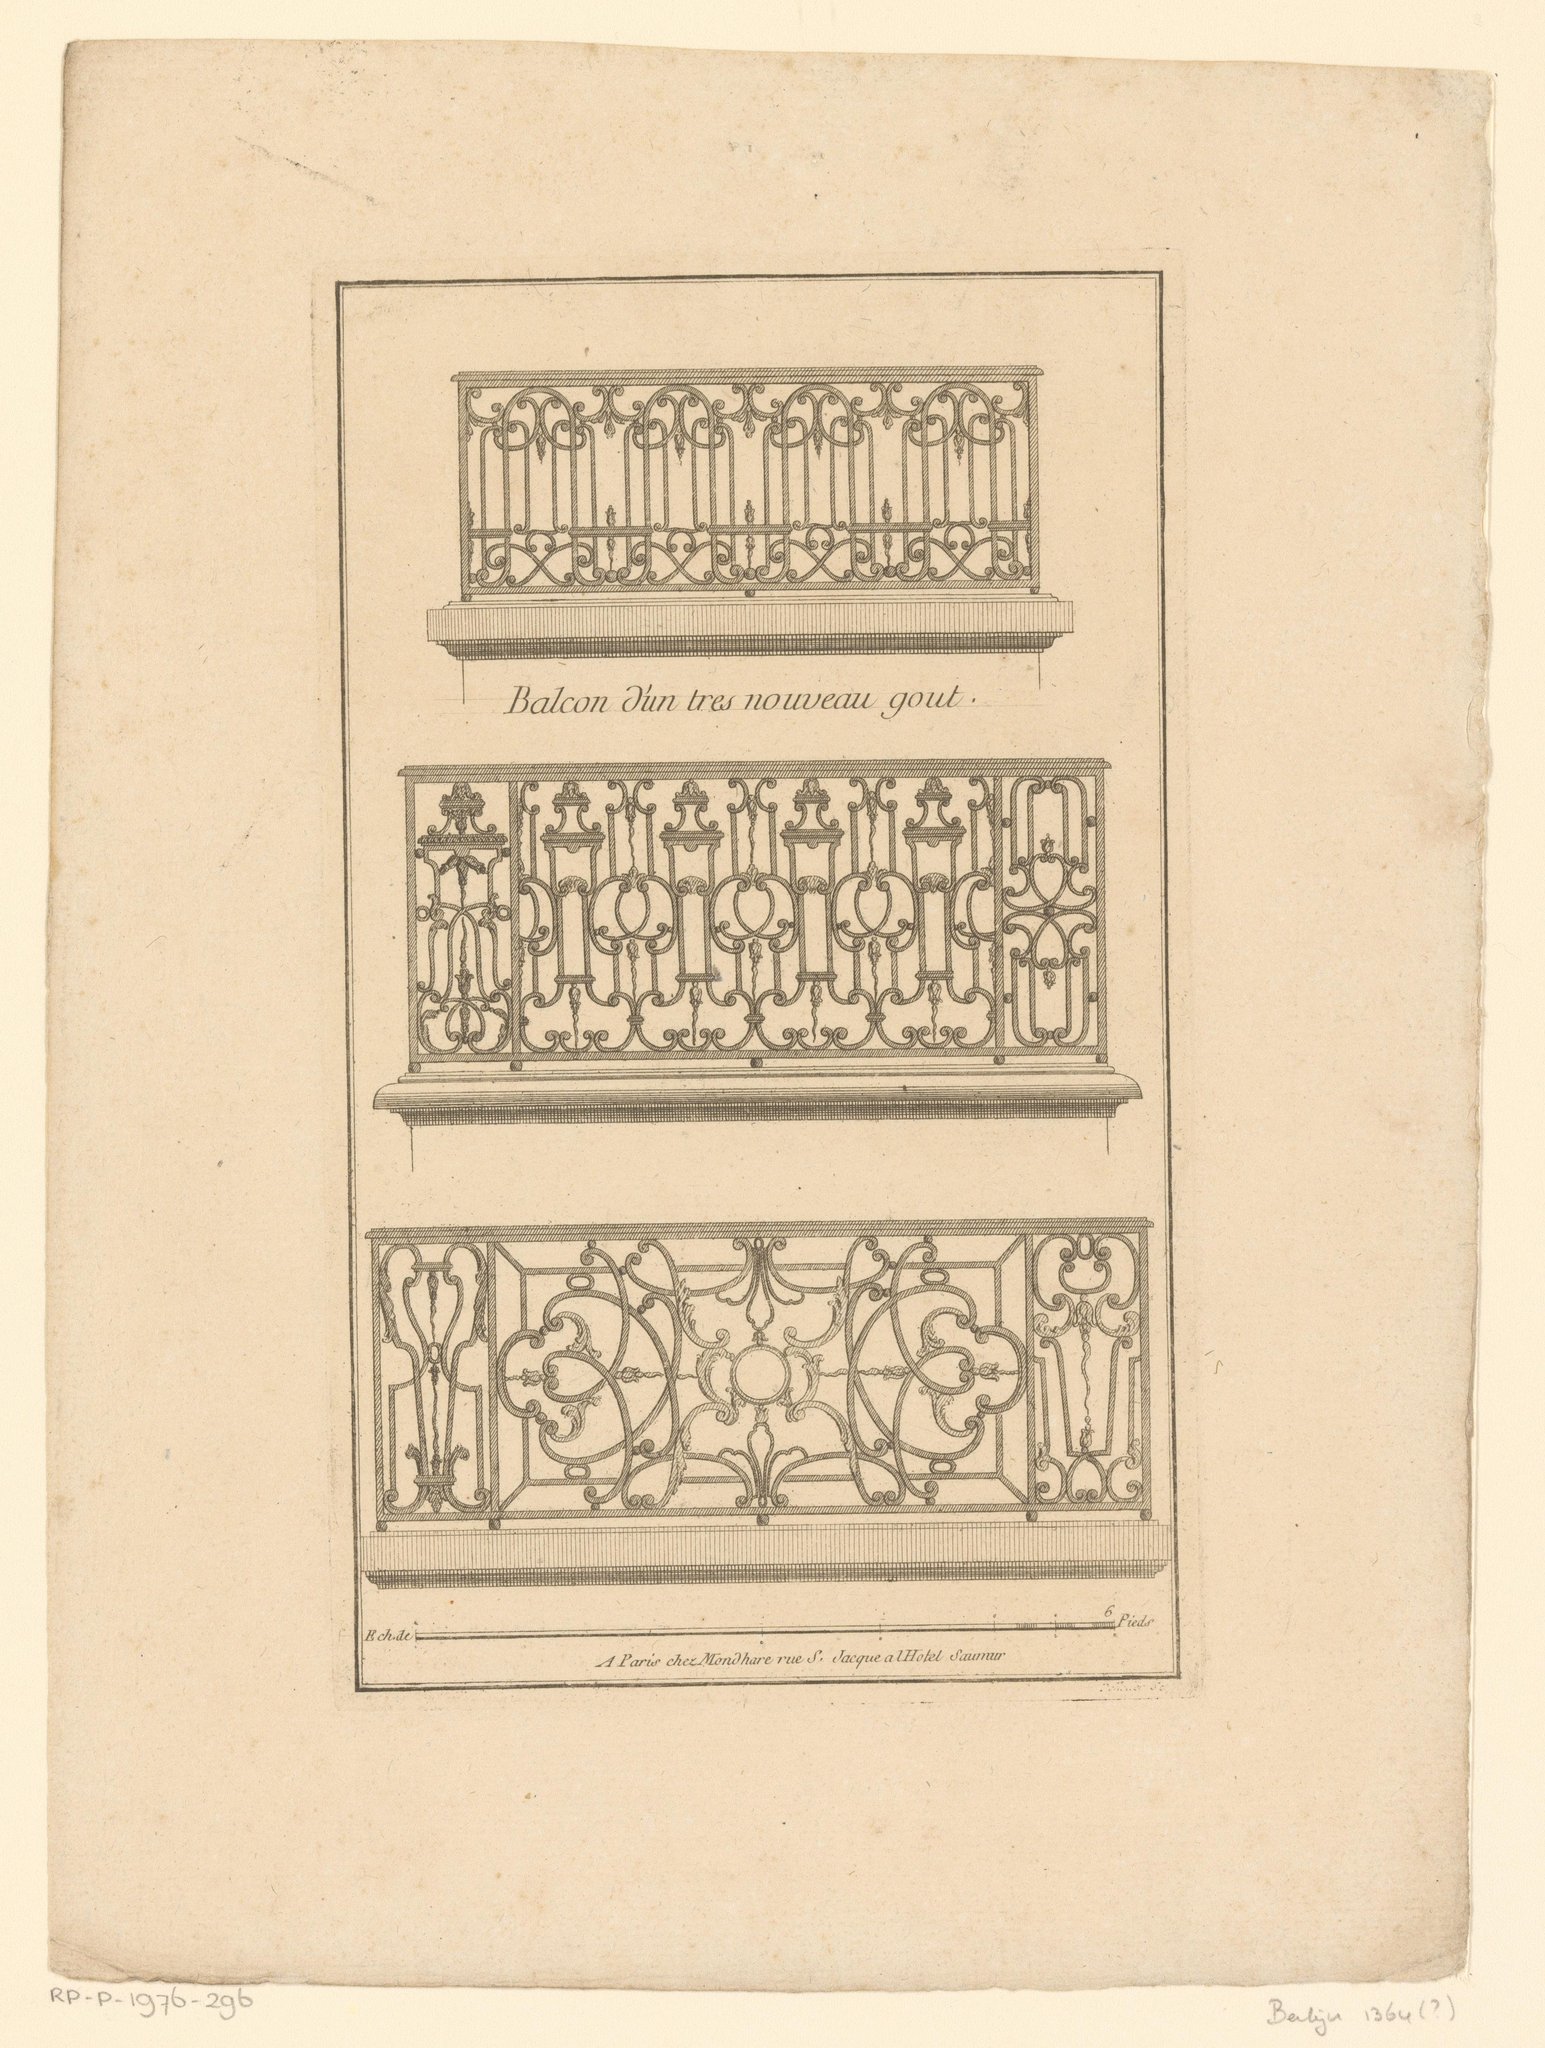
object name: print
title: Balcon d'un tres nouveau gout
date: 1761-1762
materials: paper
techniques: engraving, etching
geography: paris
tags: balcony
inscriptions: collector's mark: Lugt 2228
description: Prent mogelijk onderdeel van serie Nouveau Receuil De Serrurerie.